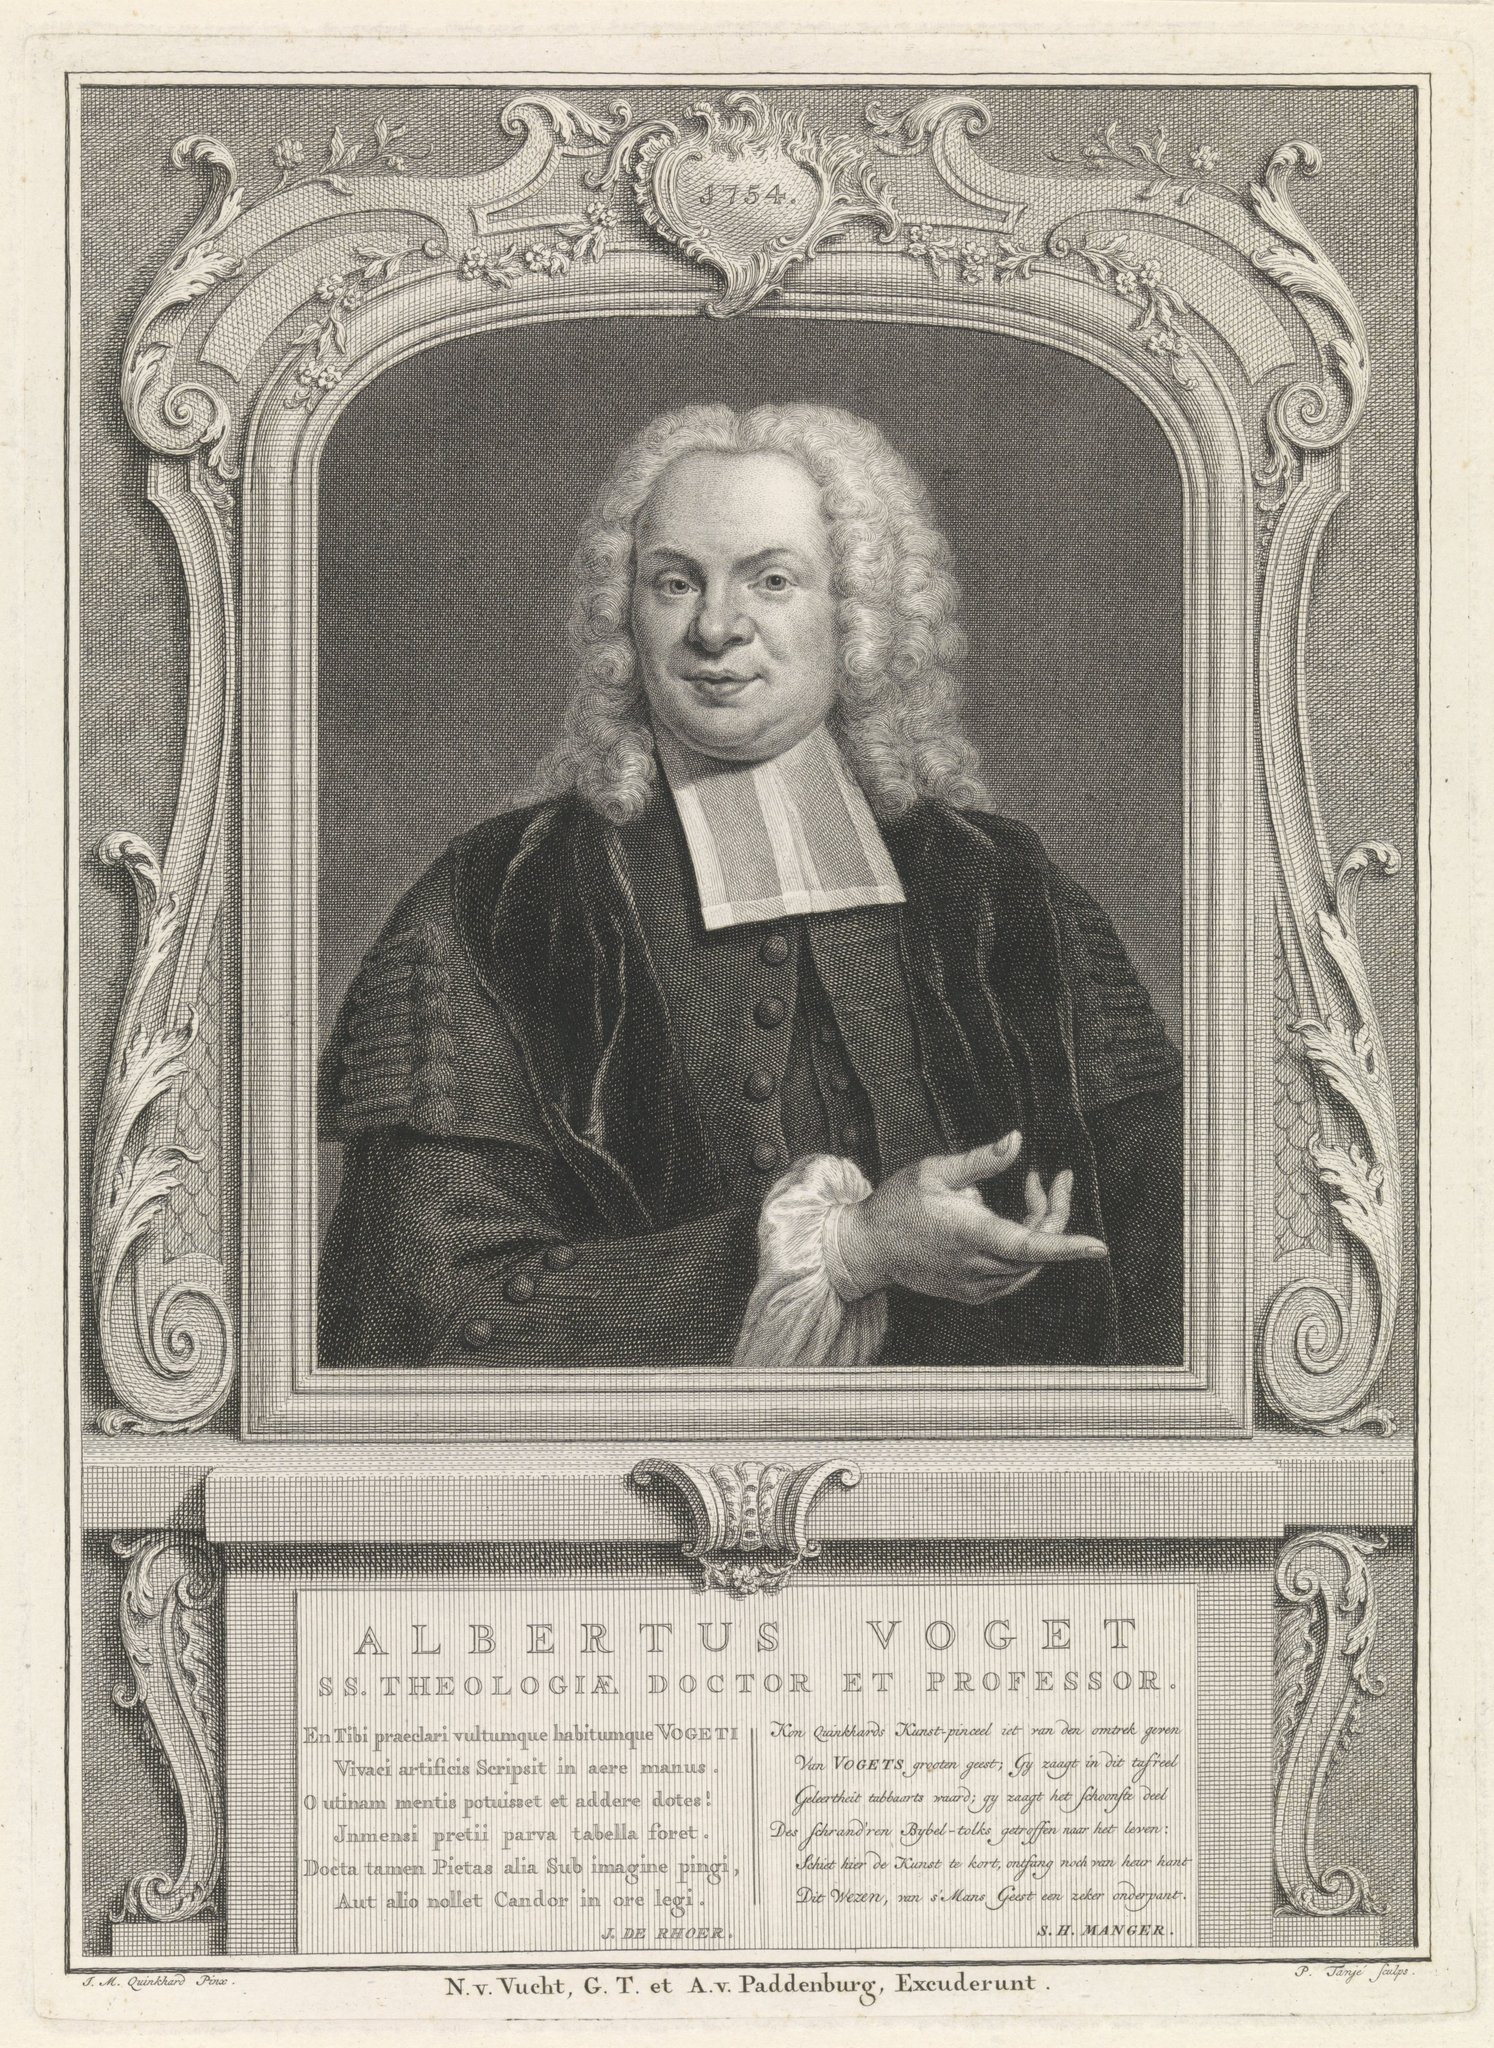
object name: print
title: Portret van Albertus Voget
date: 1716-1761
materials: paper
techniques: engraving, etching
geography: amsterdam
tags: utrecht, albertus voget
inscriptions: collector's mark: Lugt 240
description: Portret van Albertus Voget, predikant en hoogleraar in de theologie, in een ornamentele lijst. Onder het portret een zesregelig vers in het Latijn en in het Nederlands.